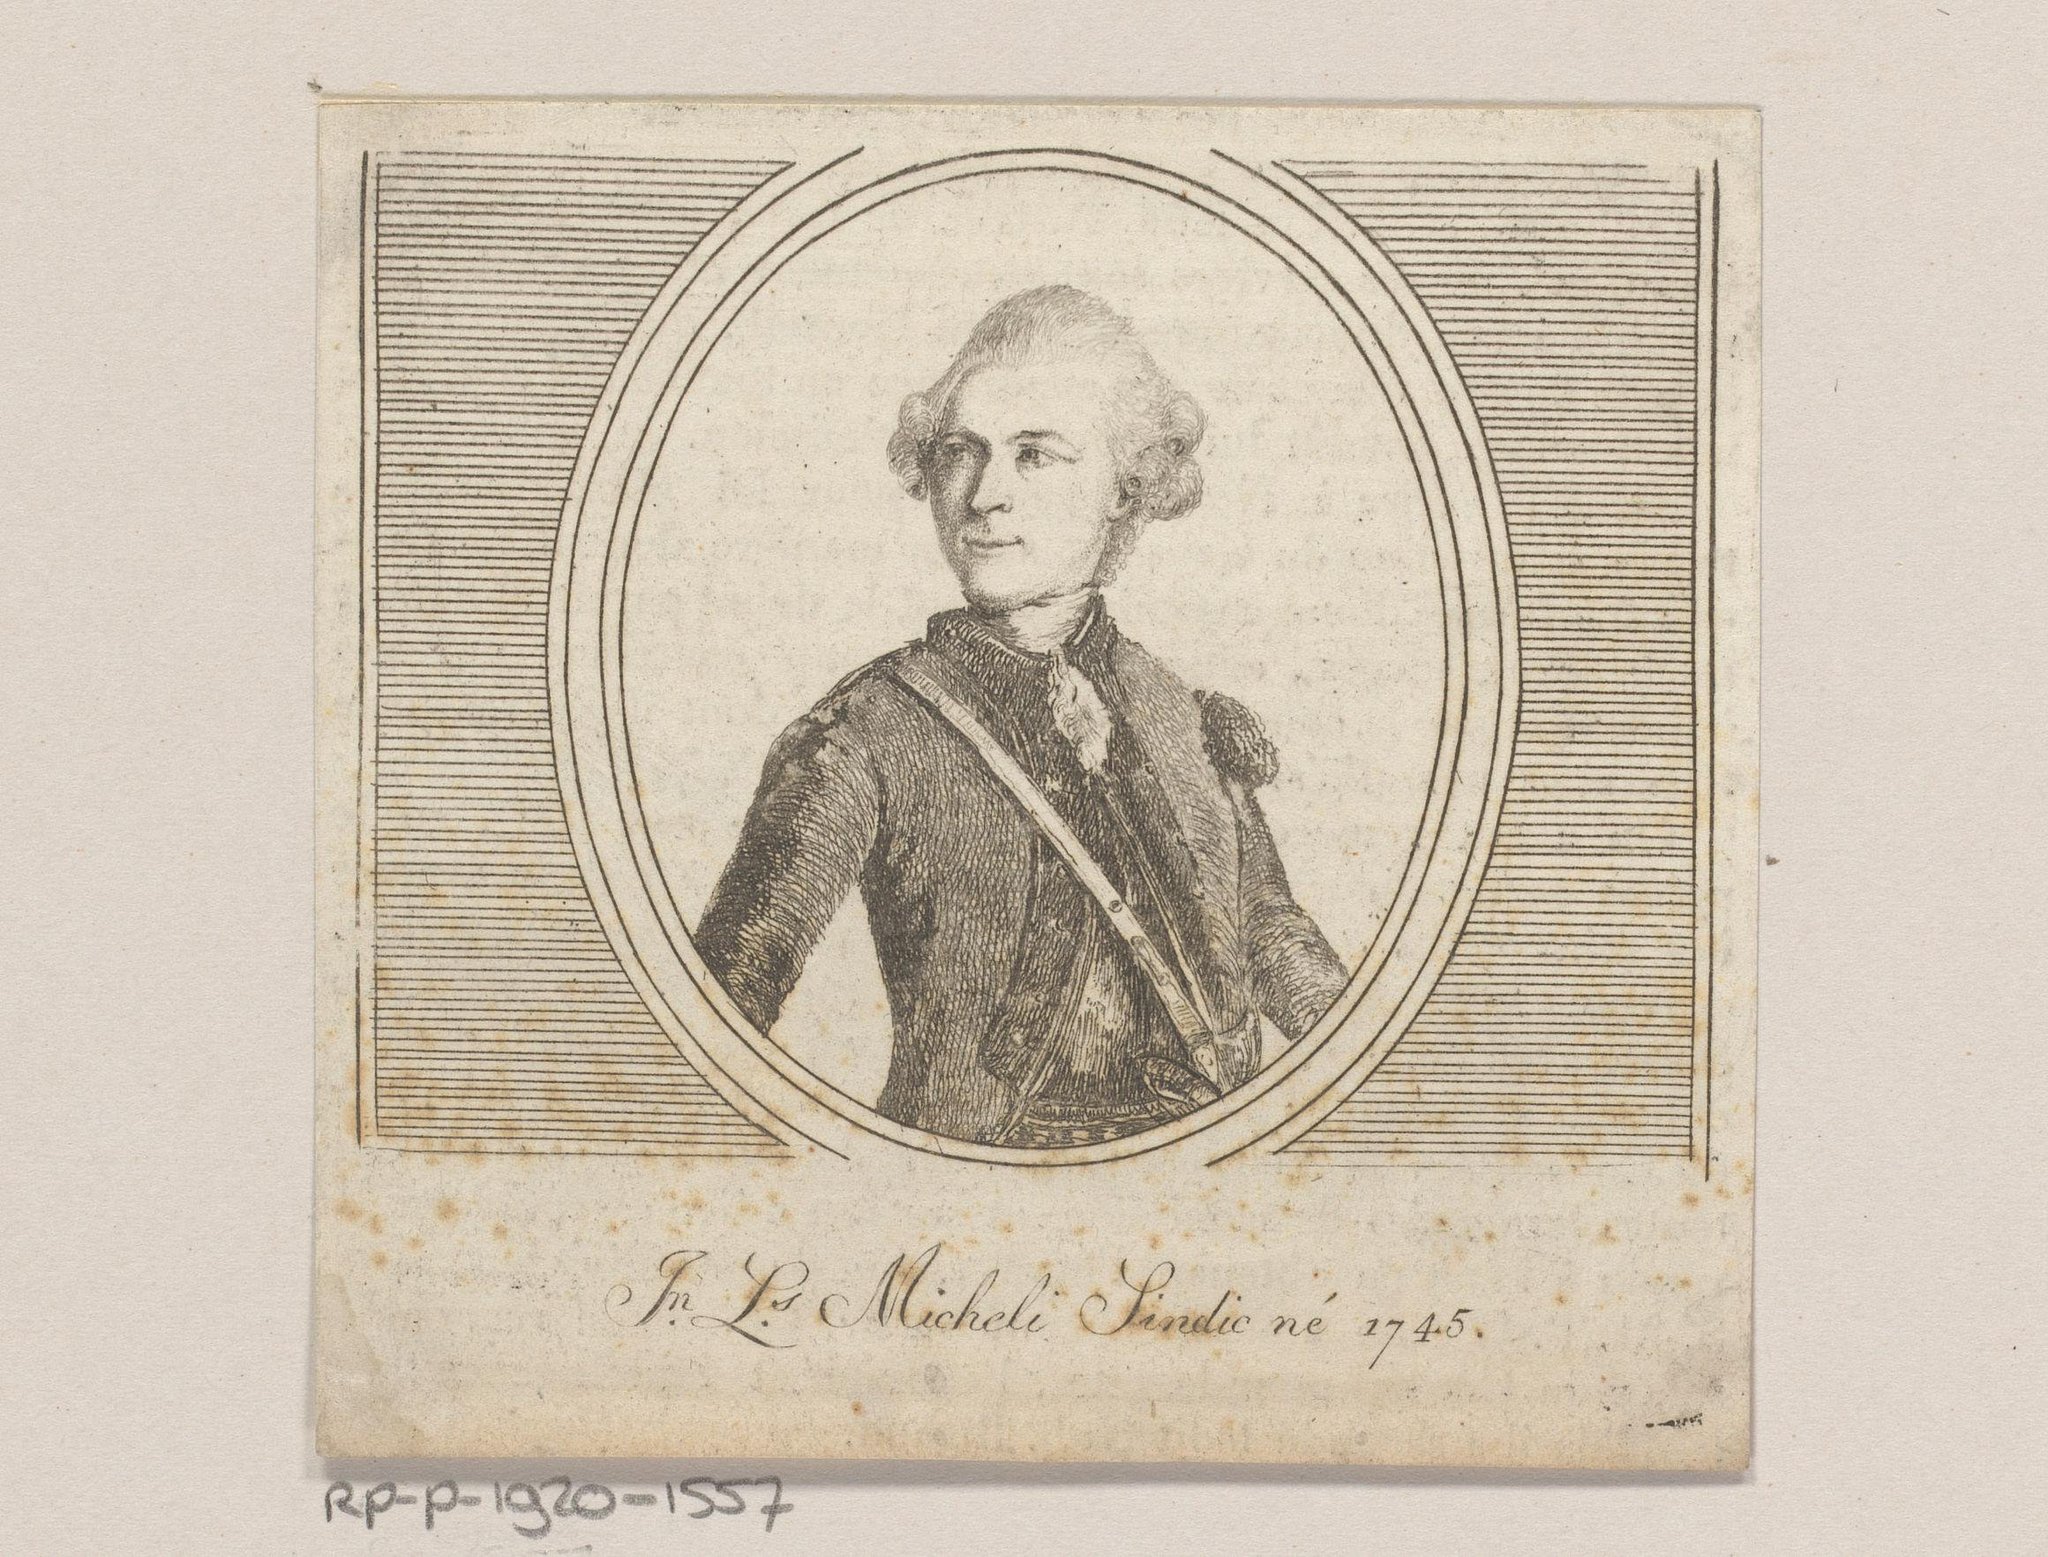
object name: print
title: Portret van Jean-Louis Micheli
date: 1815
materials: paper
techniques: etching, letterpress printing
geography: geneva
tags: politician, historical persons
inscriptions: collector's mark: Lugt 2228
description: Prent uit: Grenus, Théodore de. Fragmens biographiques et historiques: extraits des registres du Conseil d'Etat de la République de Genève, dès 1535 à 1792. Genève: Manget en Cherbuliez, 1815, p. 411.